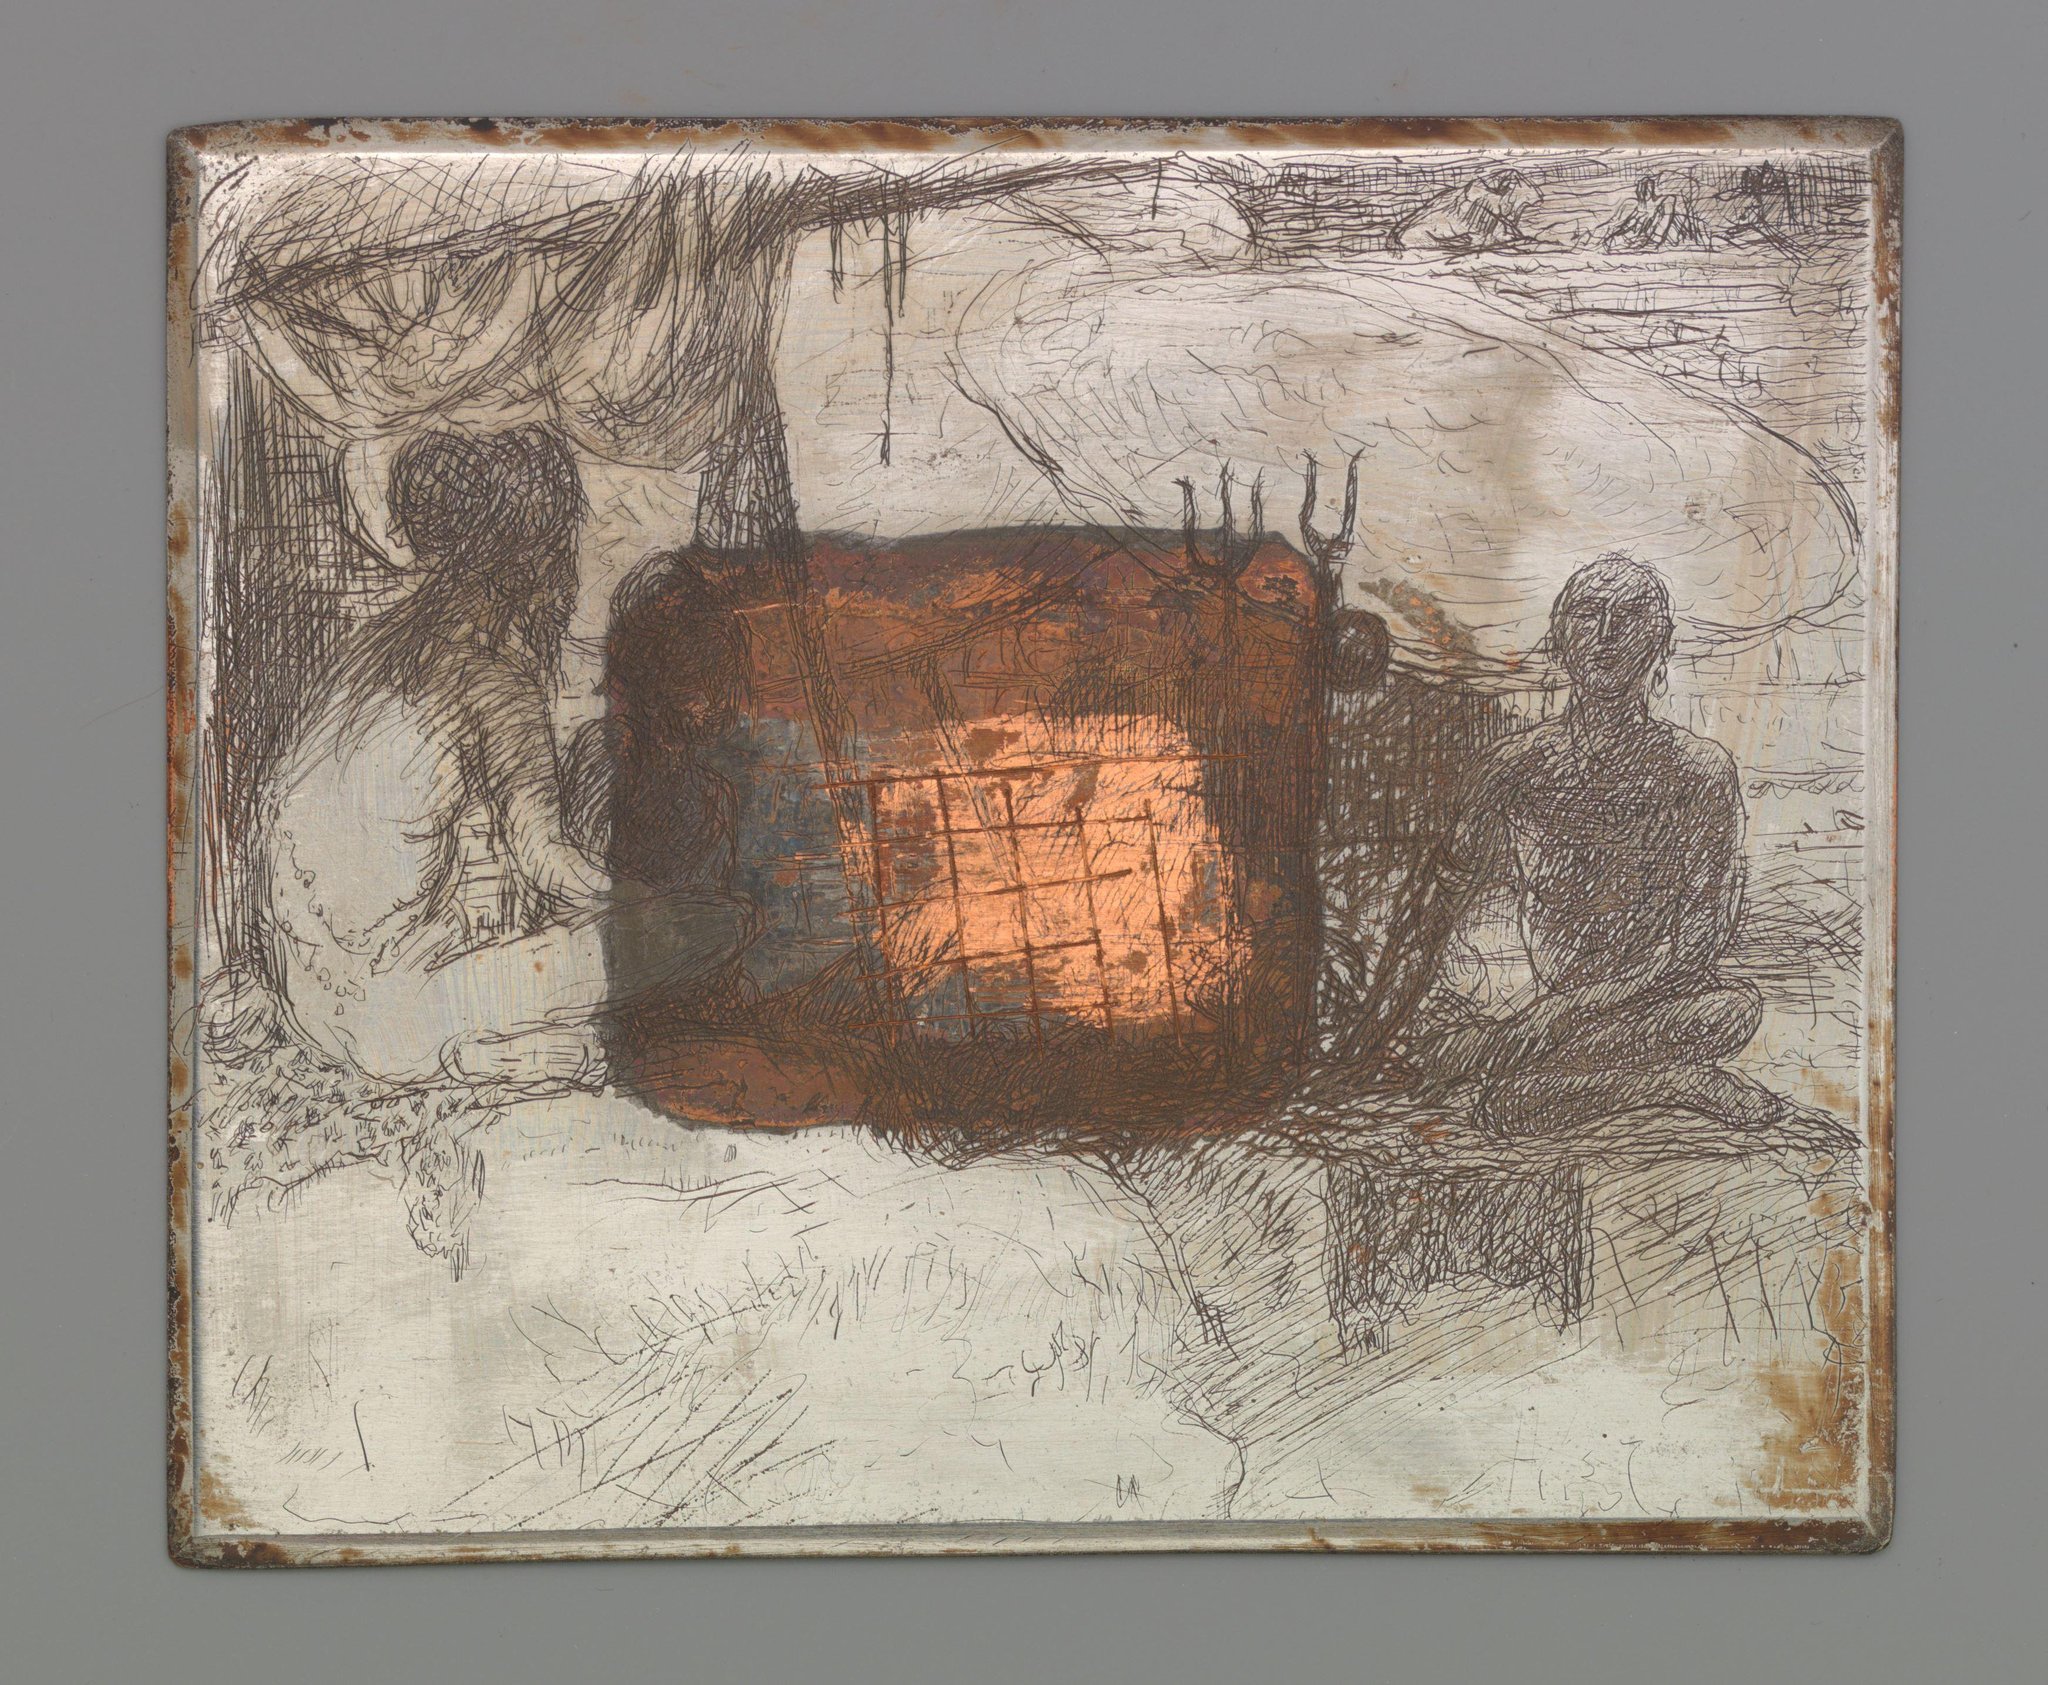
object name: copper plate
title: Indische waarzegger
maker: marius bauer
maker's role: draughtsman, print maker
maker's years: 1867-1932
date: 1924-1932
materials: copper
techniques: etching